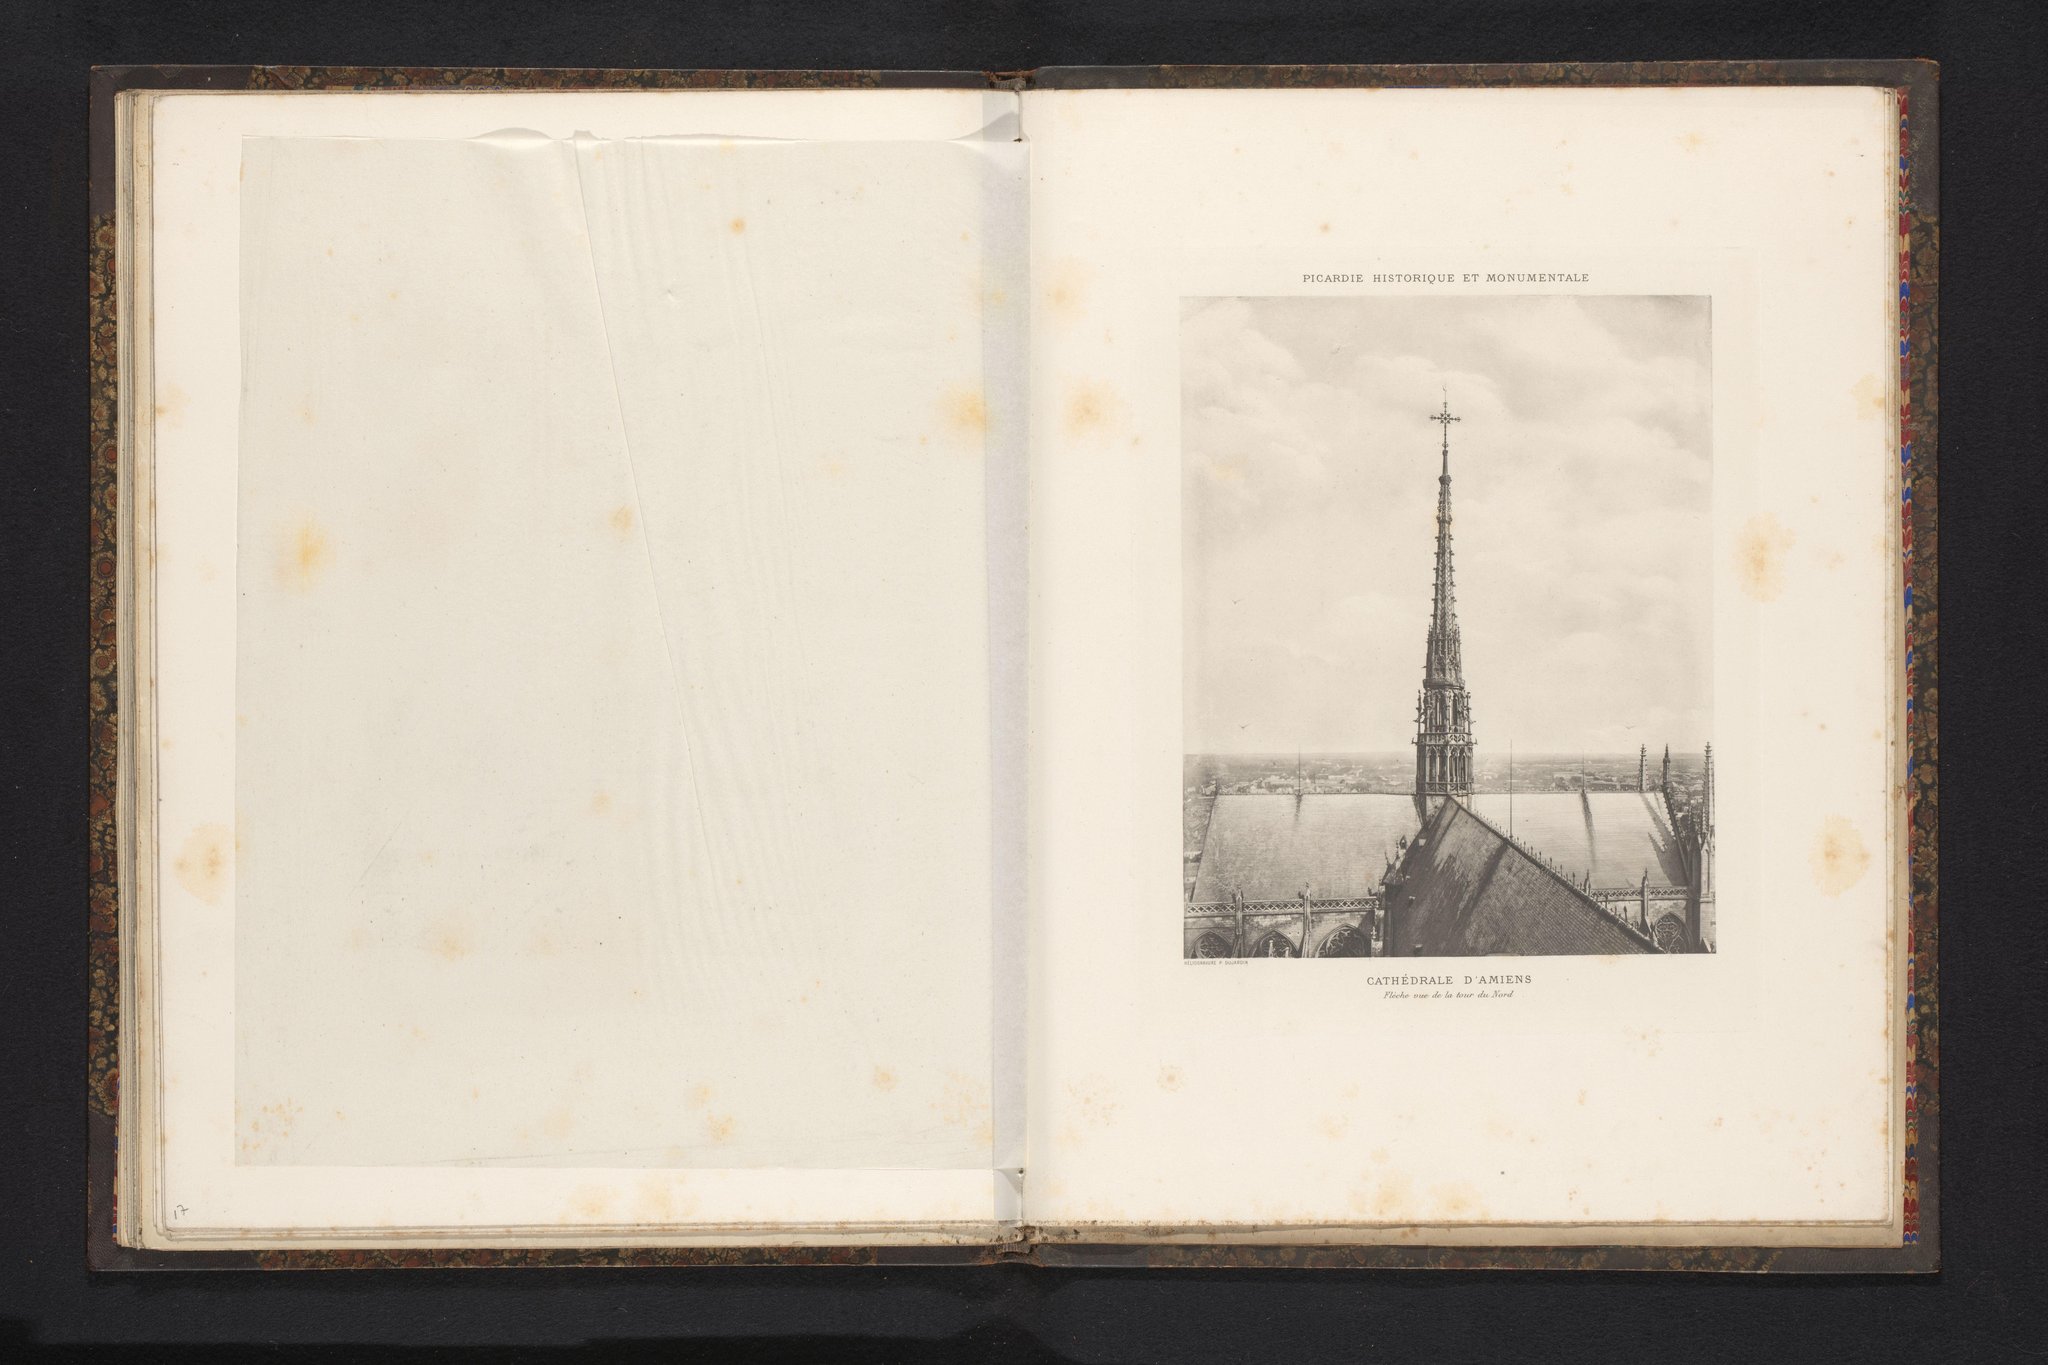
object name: photomechanical print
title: Toren op de Notre-Dame van Amiens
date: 1888-1893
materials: paper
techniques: photograph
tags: parts of church exterior and annexes: tower, notre-dame d'amiens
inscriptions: inscription: ‘Cathédrale d'Amiens/ Flèche oue de la tour de Nord’